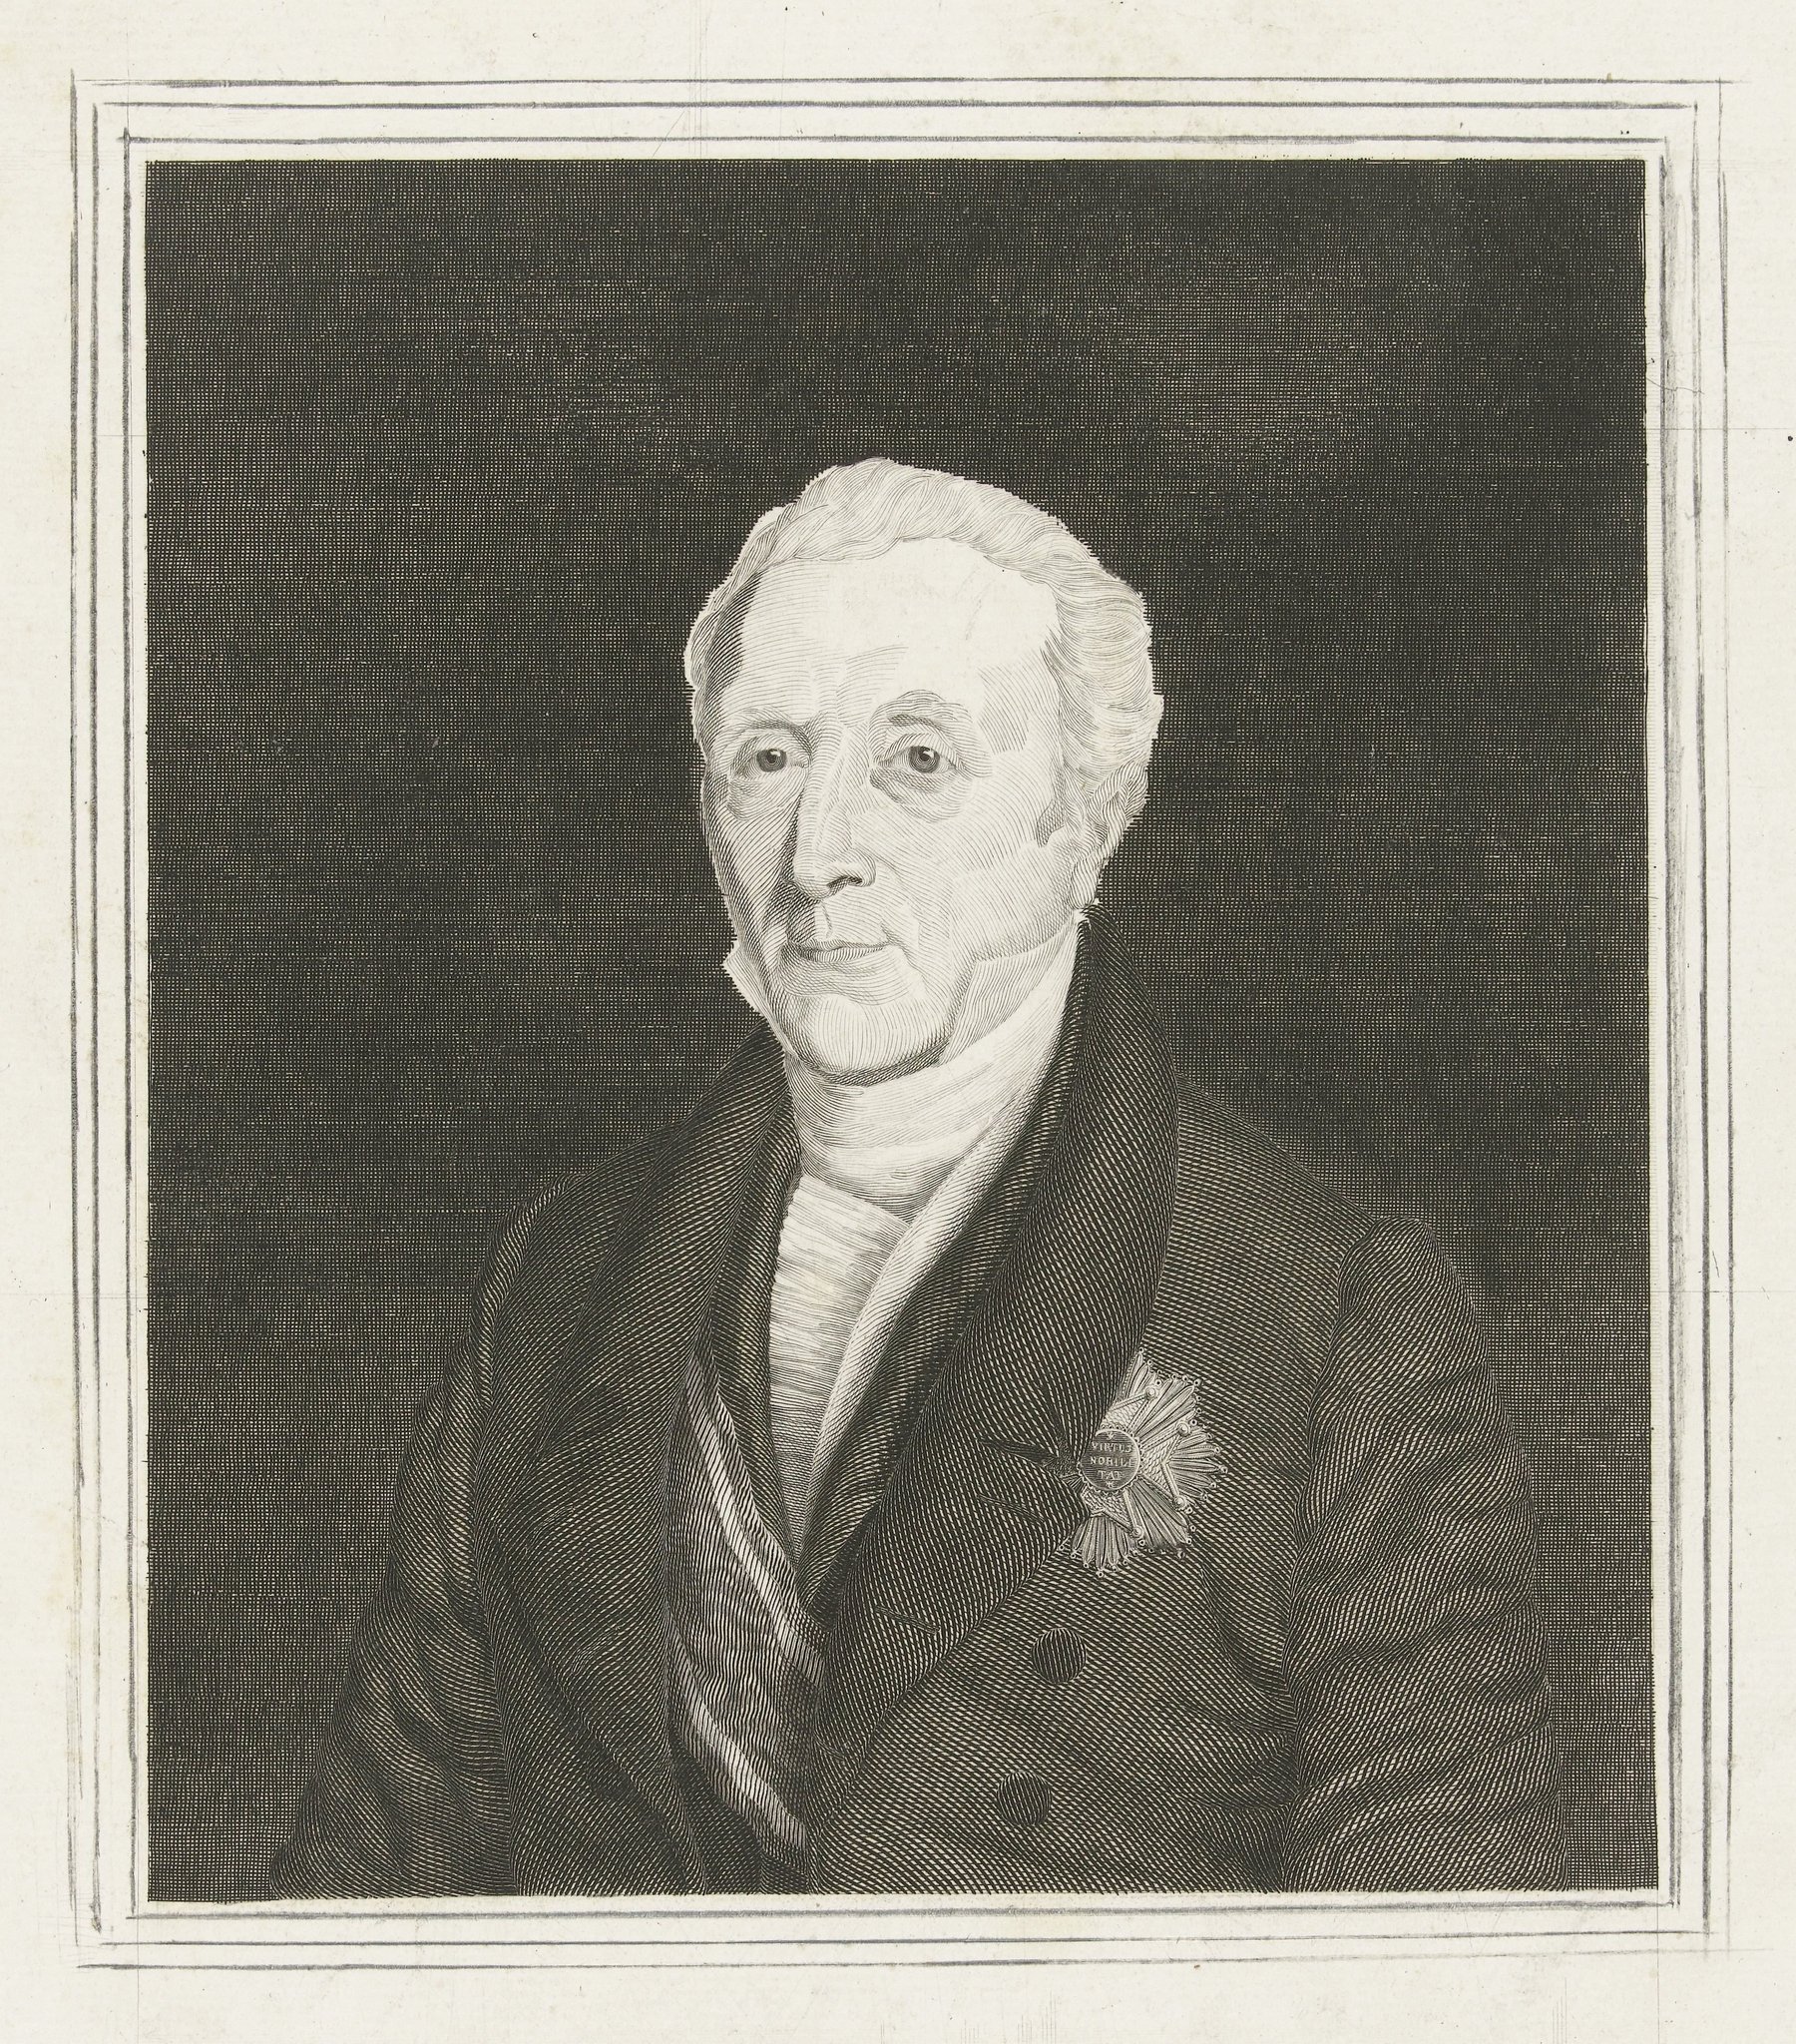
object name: print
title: Portret van Willem Frederik baron van Roëll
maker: henricus wilhelmus couwenberg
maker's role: draughtsman, print maker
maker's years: 1814-1845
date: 1835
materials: paper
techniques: engraving, etching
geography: amsterdam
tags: amsterdam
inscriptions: collector's mark: Lugt 2228